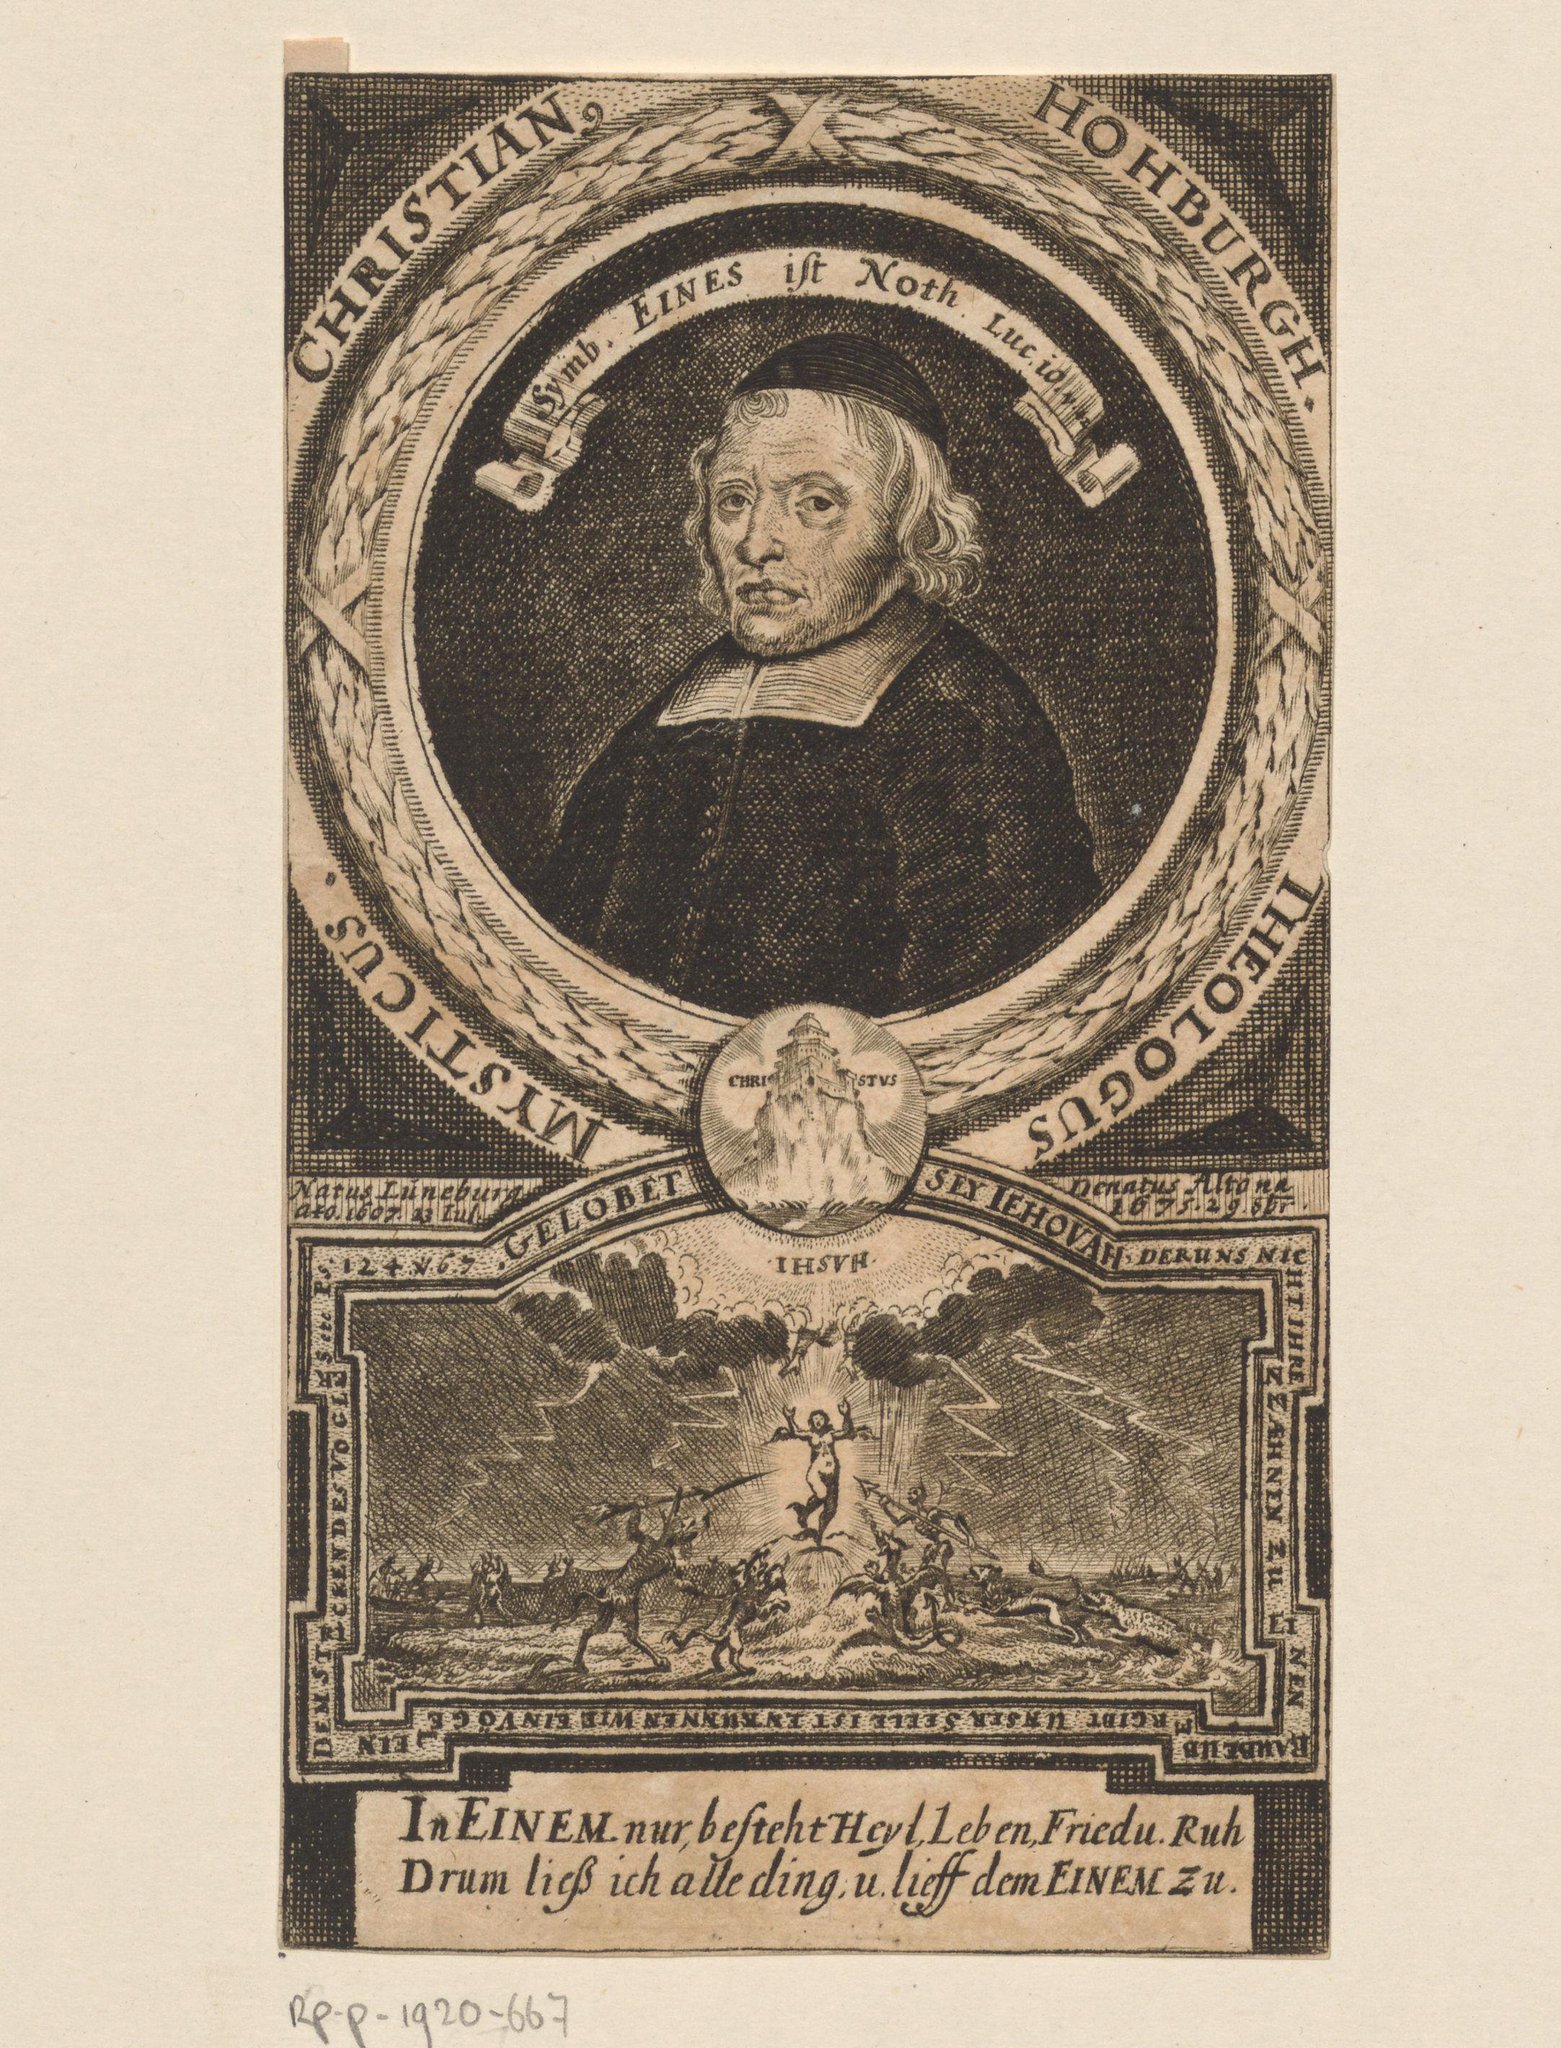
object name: print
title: Portret van Christian Hohburg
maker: Anonymous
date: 1675-1750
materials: paper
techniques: engraving, etching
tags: adult man, historical persons, devil or demons attacking mortals, lightning, flash of lightning, thunderbolt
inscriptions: collector's mark: Lugt 2228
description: Prent mogelijk uit een uitgave van: Hohburg, Christian. Teutsch-Evangelisches Judenthum.